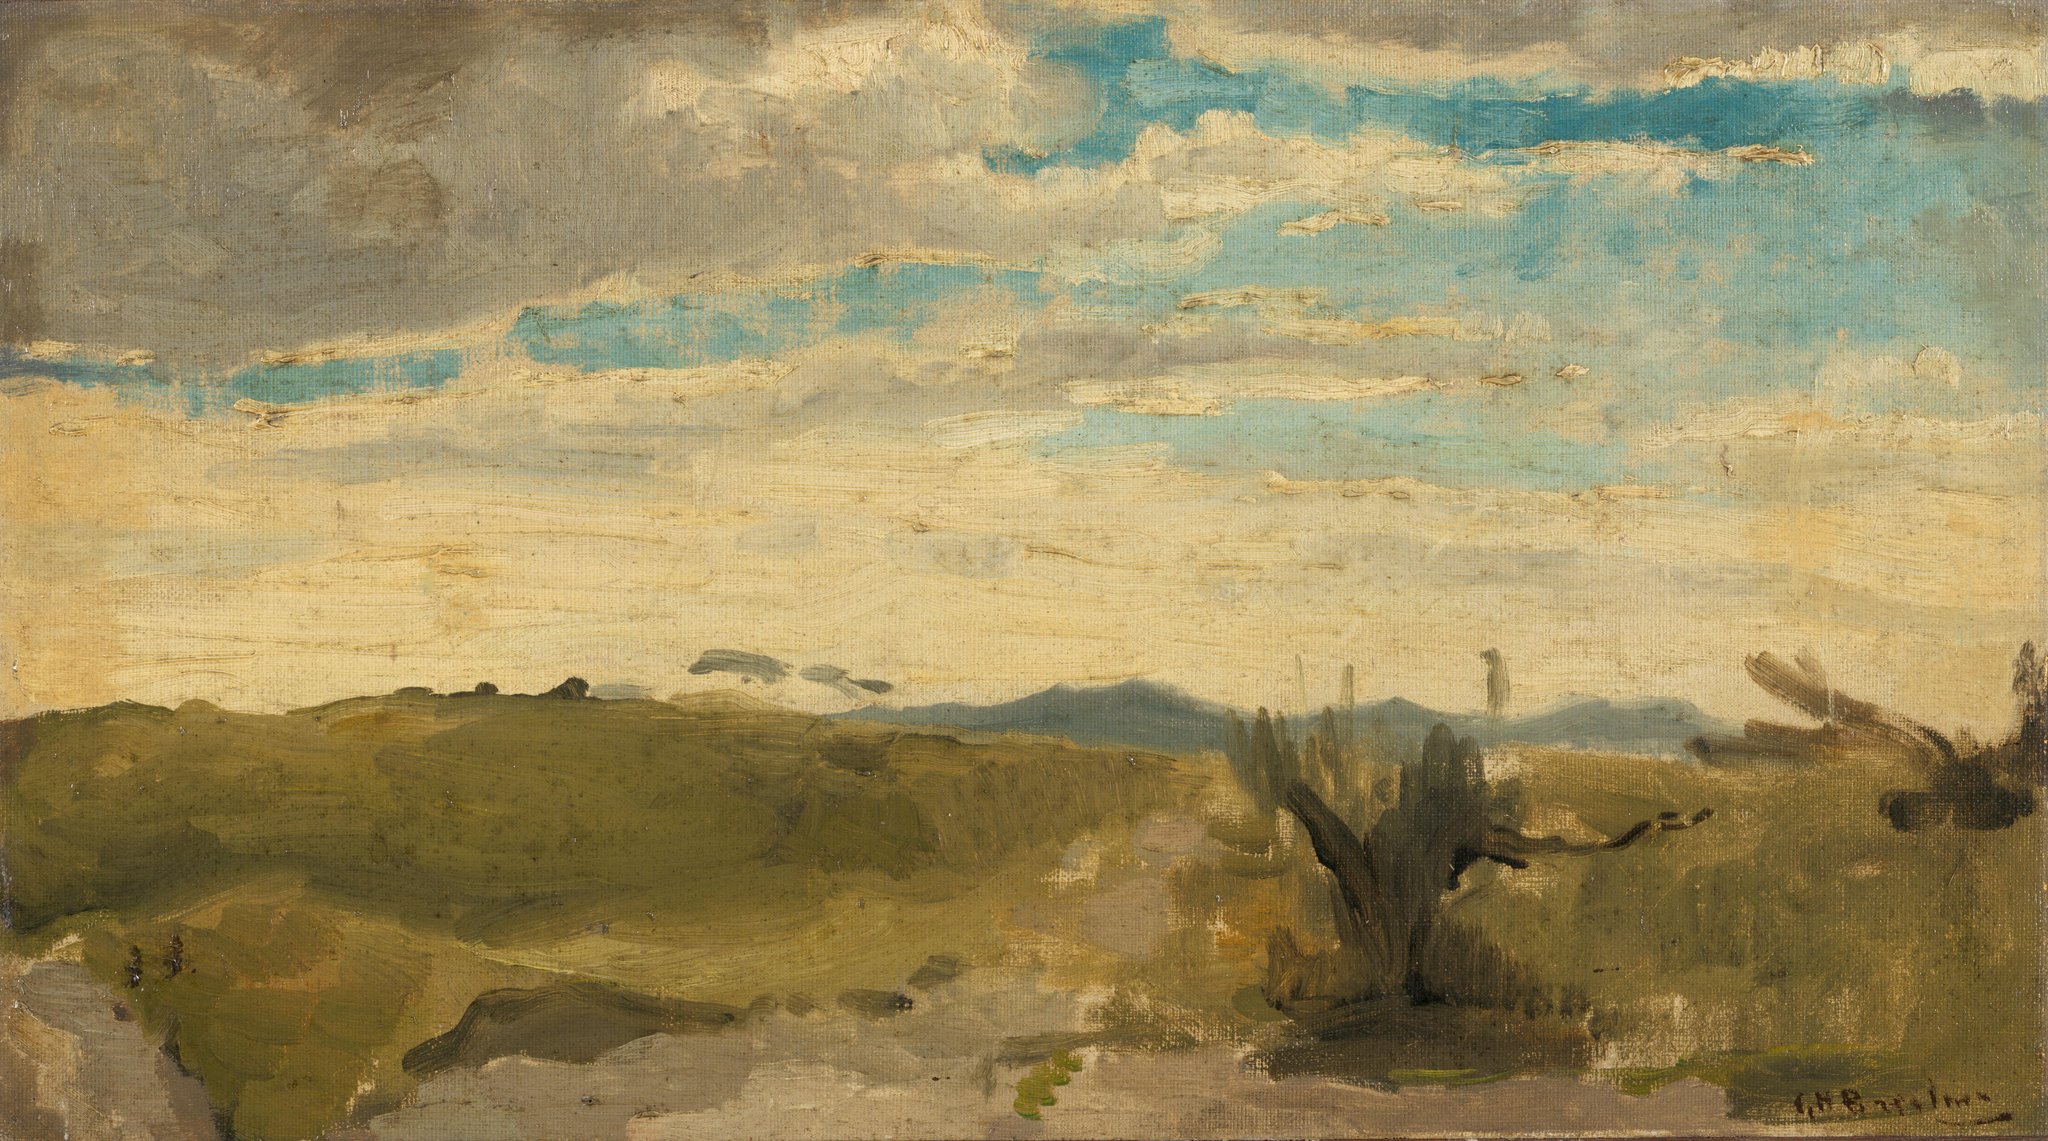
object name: painting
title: View in the Dunes near Dekkersduin, The Hague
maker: george hendrik breitner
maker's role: draughtsman, painter, print maker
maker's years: 1857-1923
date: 1875-1885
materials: canvas, oil, panel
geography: netherlands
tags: dunes (sea not visible); in the dunes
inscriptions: signature: ‘G.H. Breitner’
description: Duinlandschap bij Dekkersduin, Den Haag.